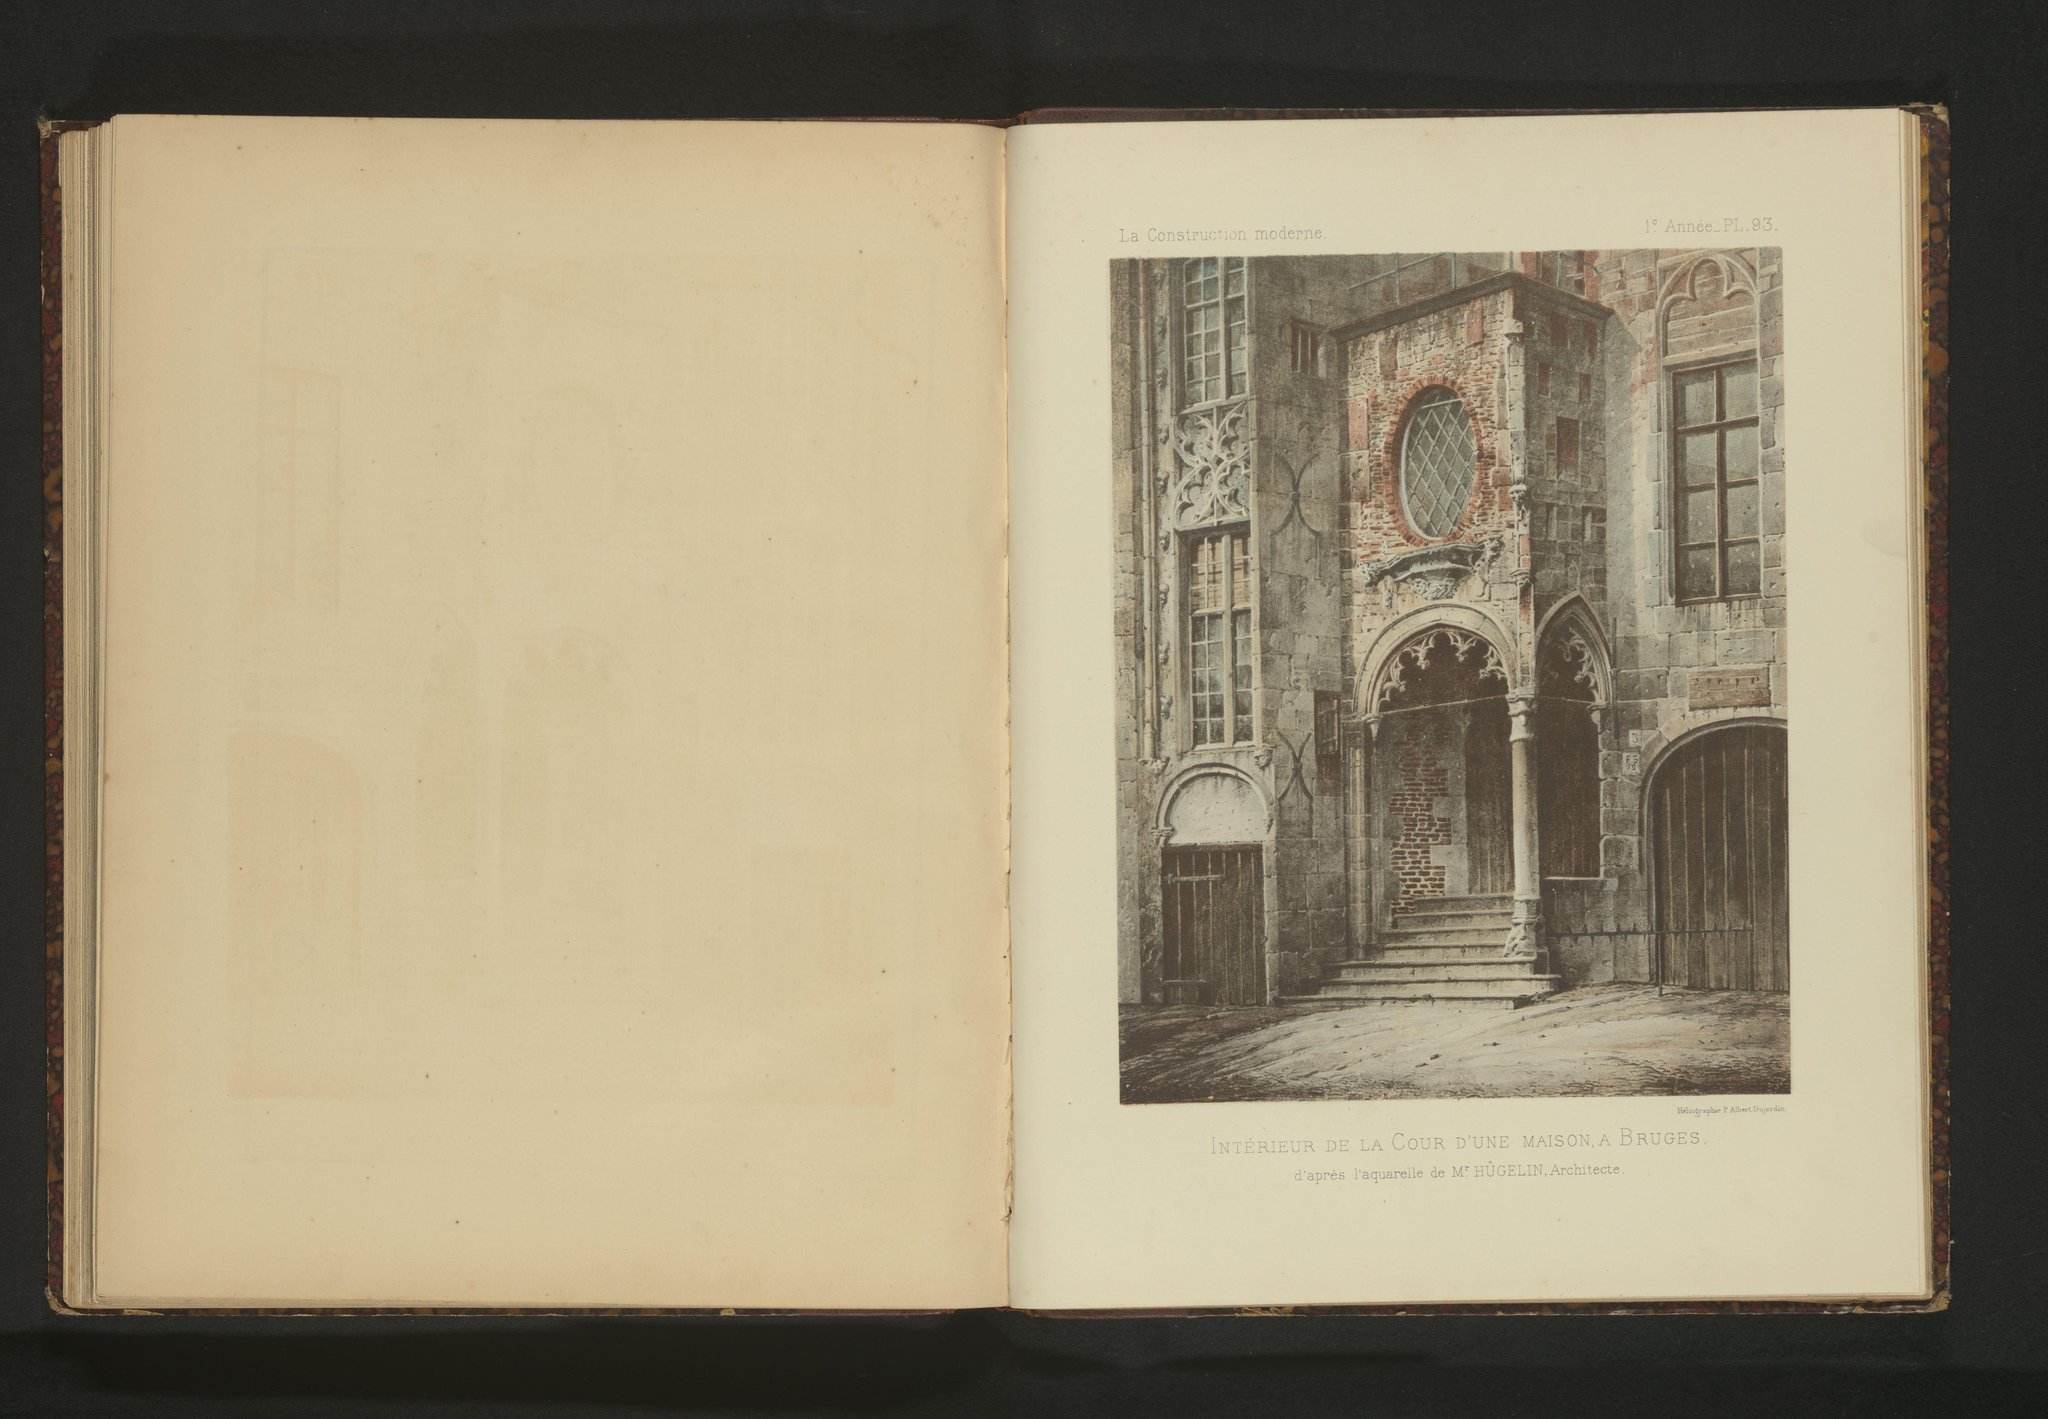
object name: print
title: Reproductie van een aquarel van de binnenplaats van een huis in Brugge door M. Hügelin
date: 1881-1886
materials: paper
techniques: photograph, lithograph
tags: monumental door, porch, 'aediculum', courtyard, bruges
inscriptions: inscription: ‘d'après l'aquarelle de Mr. HÜGELIN, Architecte’, inscription: ‘1ère Année: LA CONSTRUCTION MODERNE Pl. 93’